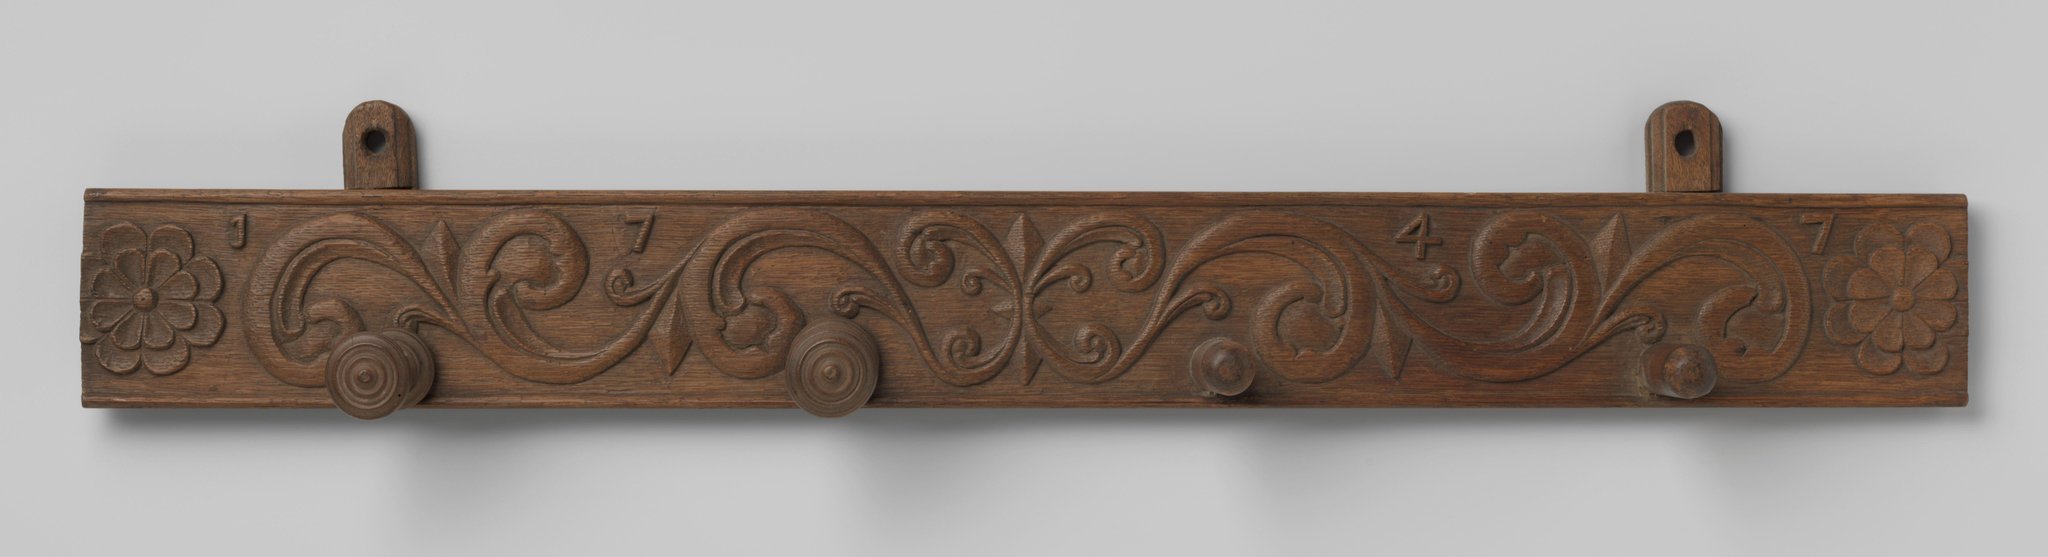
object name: hall stand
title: Meubilair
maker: Anonymous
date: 1747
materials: wood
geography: netherlands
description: Eikenhouten kapstok met vier knoppen en versierd met in laag reliëf gesneden krullen en het jaartal 1747.